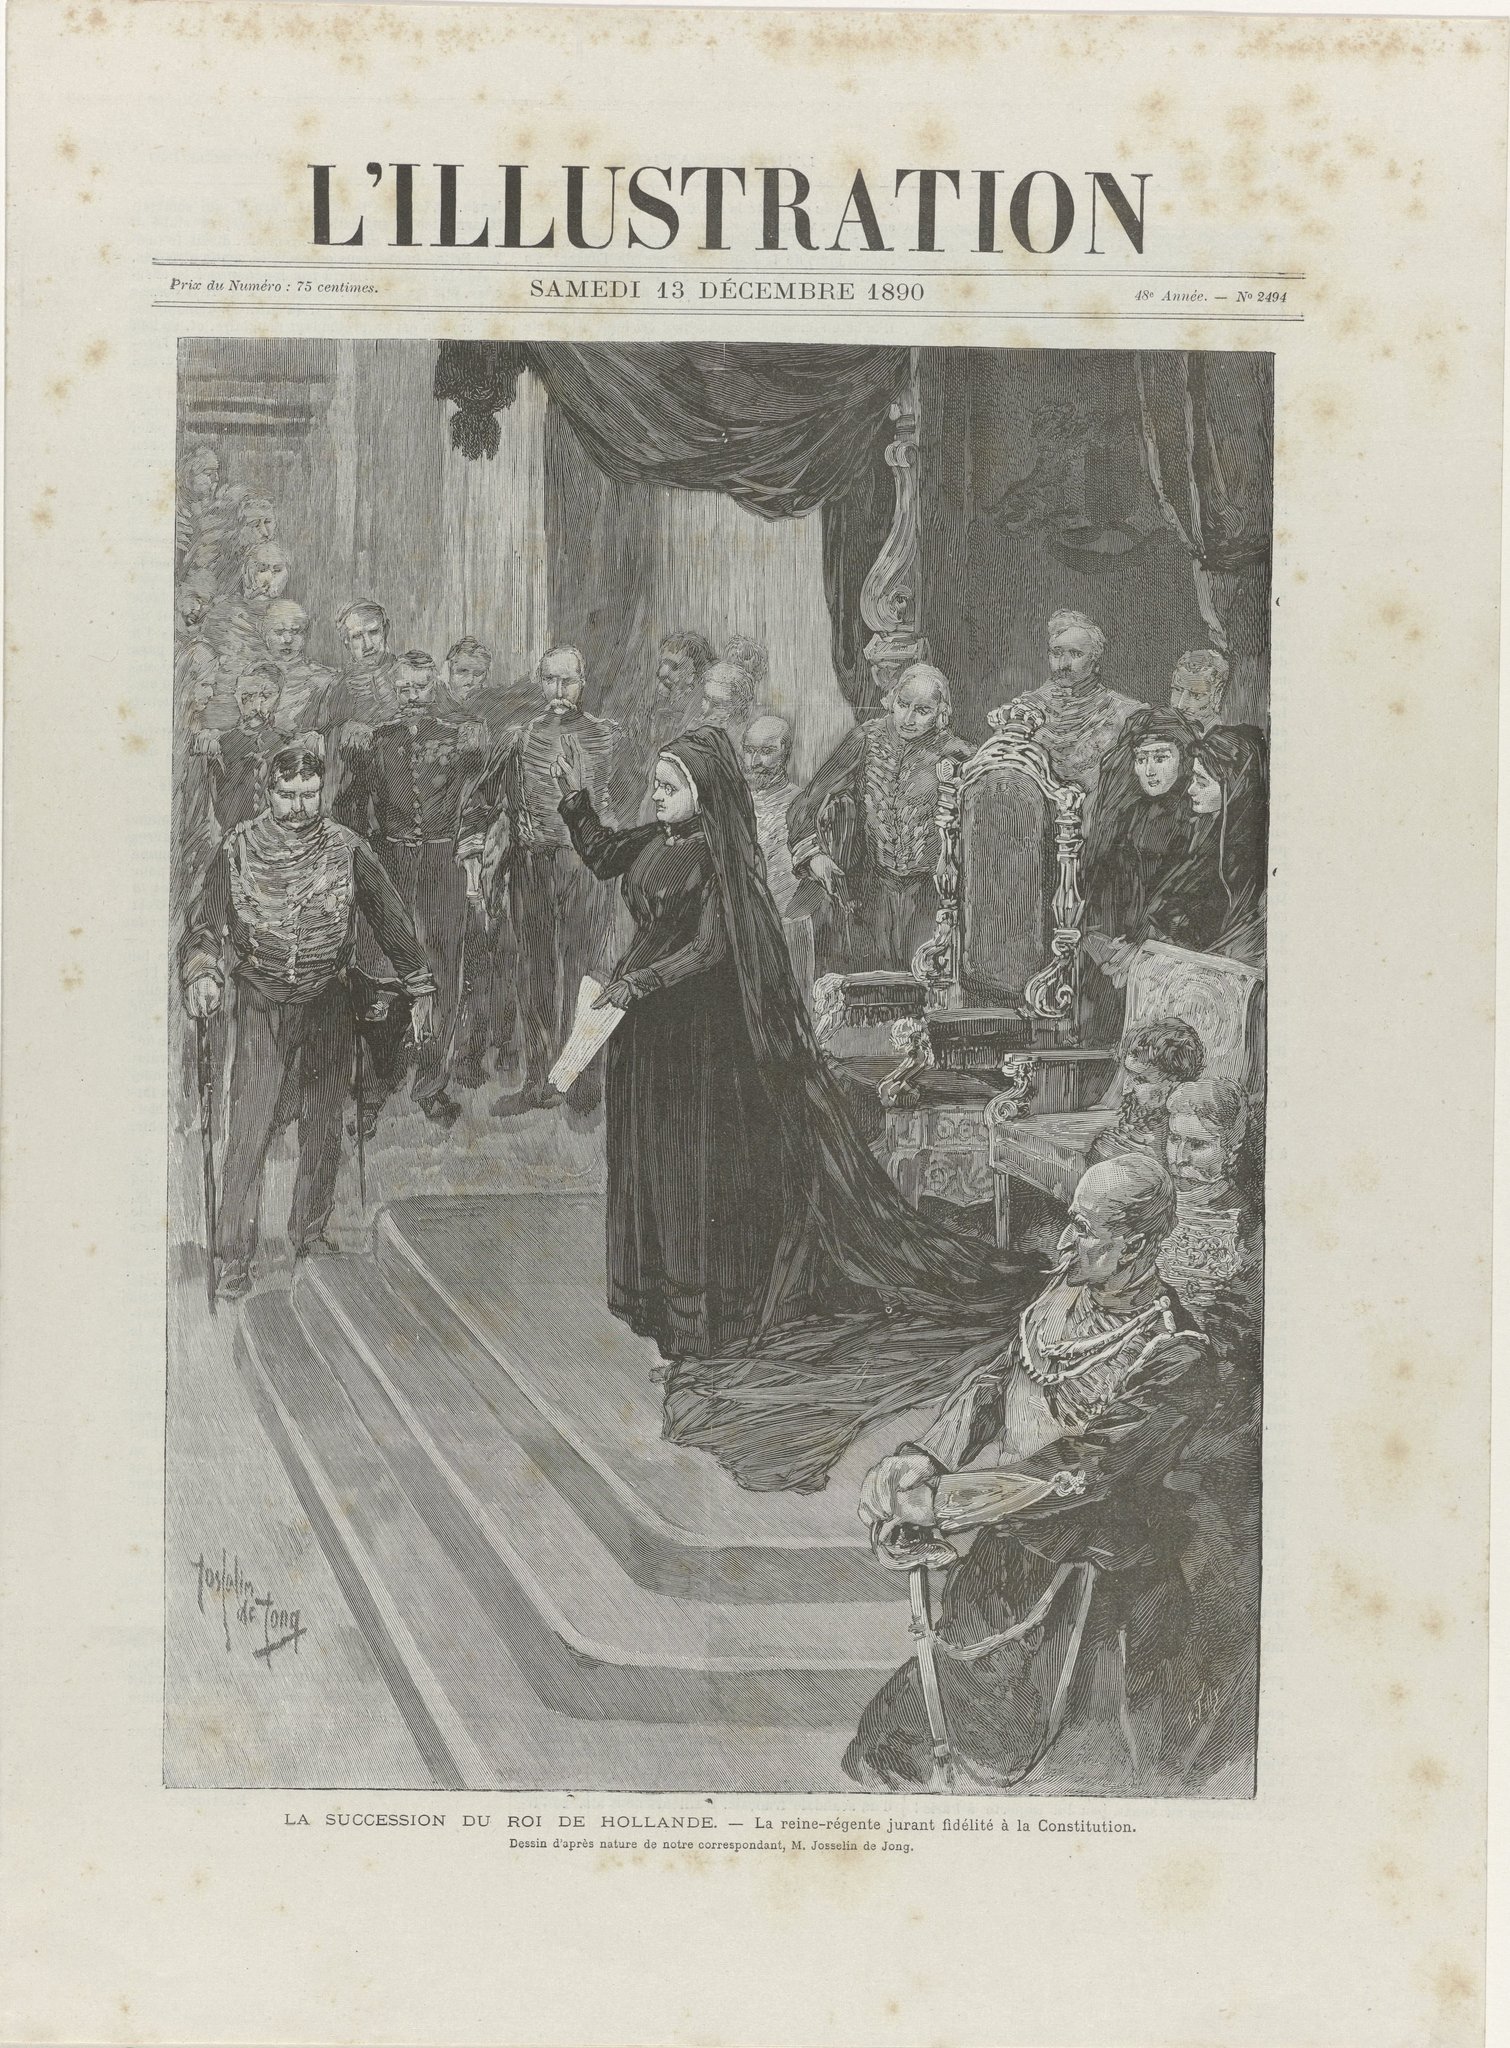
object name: newspaper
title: Krant met een artikel over het overlijden en de begrafenis van Willem III, koning der Nederlanden, op 23 november en 4 december 1890 en zijn opvolging door Emma, koningin-regentes der Nederlanden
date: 1890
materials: paper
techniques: letterpress printing, engraving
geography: paris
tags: emma (queen consort of the netherlands), willem iii (koning der nederlanden), funerary ceremonial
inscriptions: date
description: Krant met een artikel over het overlijden en de begrafenis van Willem III op 23 november en 4 december 1890 en zijn opvolging door Emma. Twee voorstellingen en kolommen en kaders met Franse tekst in boekdruk.